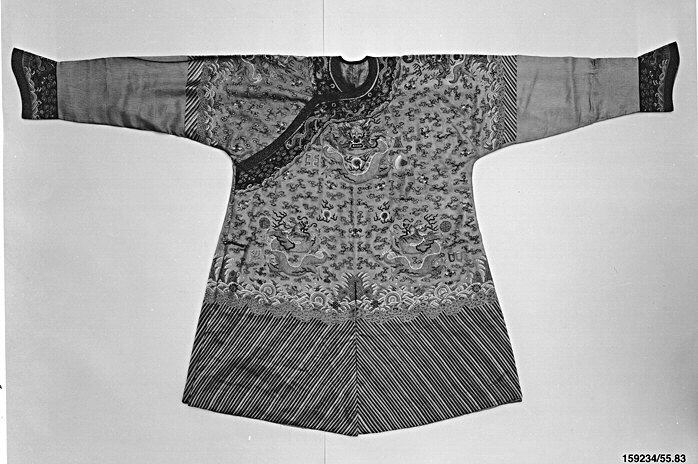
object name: robe, emperor's 12 symbol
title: Boy Emperor's Twelve-Symbol Robe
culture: chinese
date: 1801-1900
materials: metal thread, silk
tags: dragons